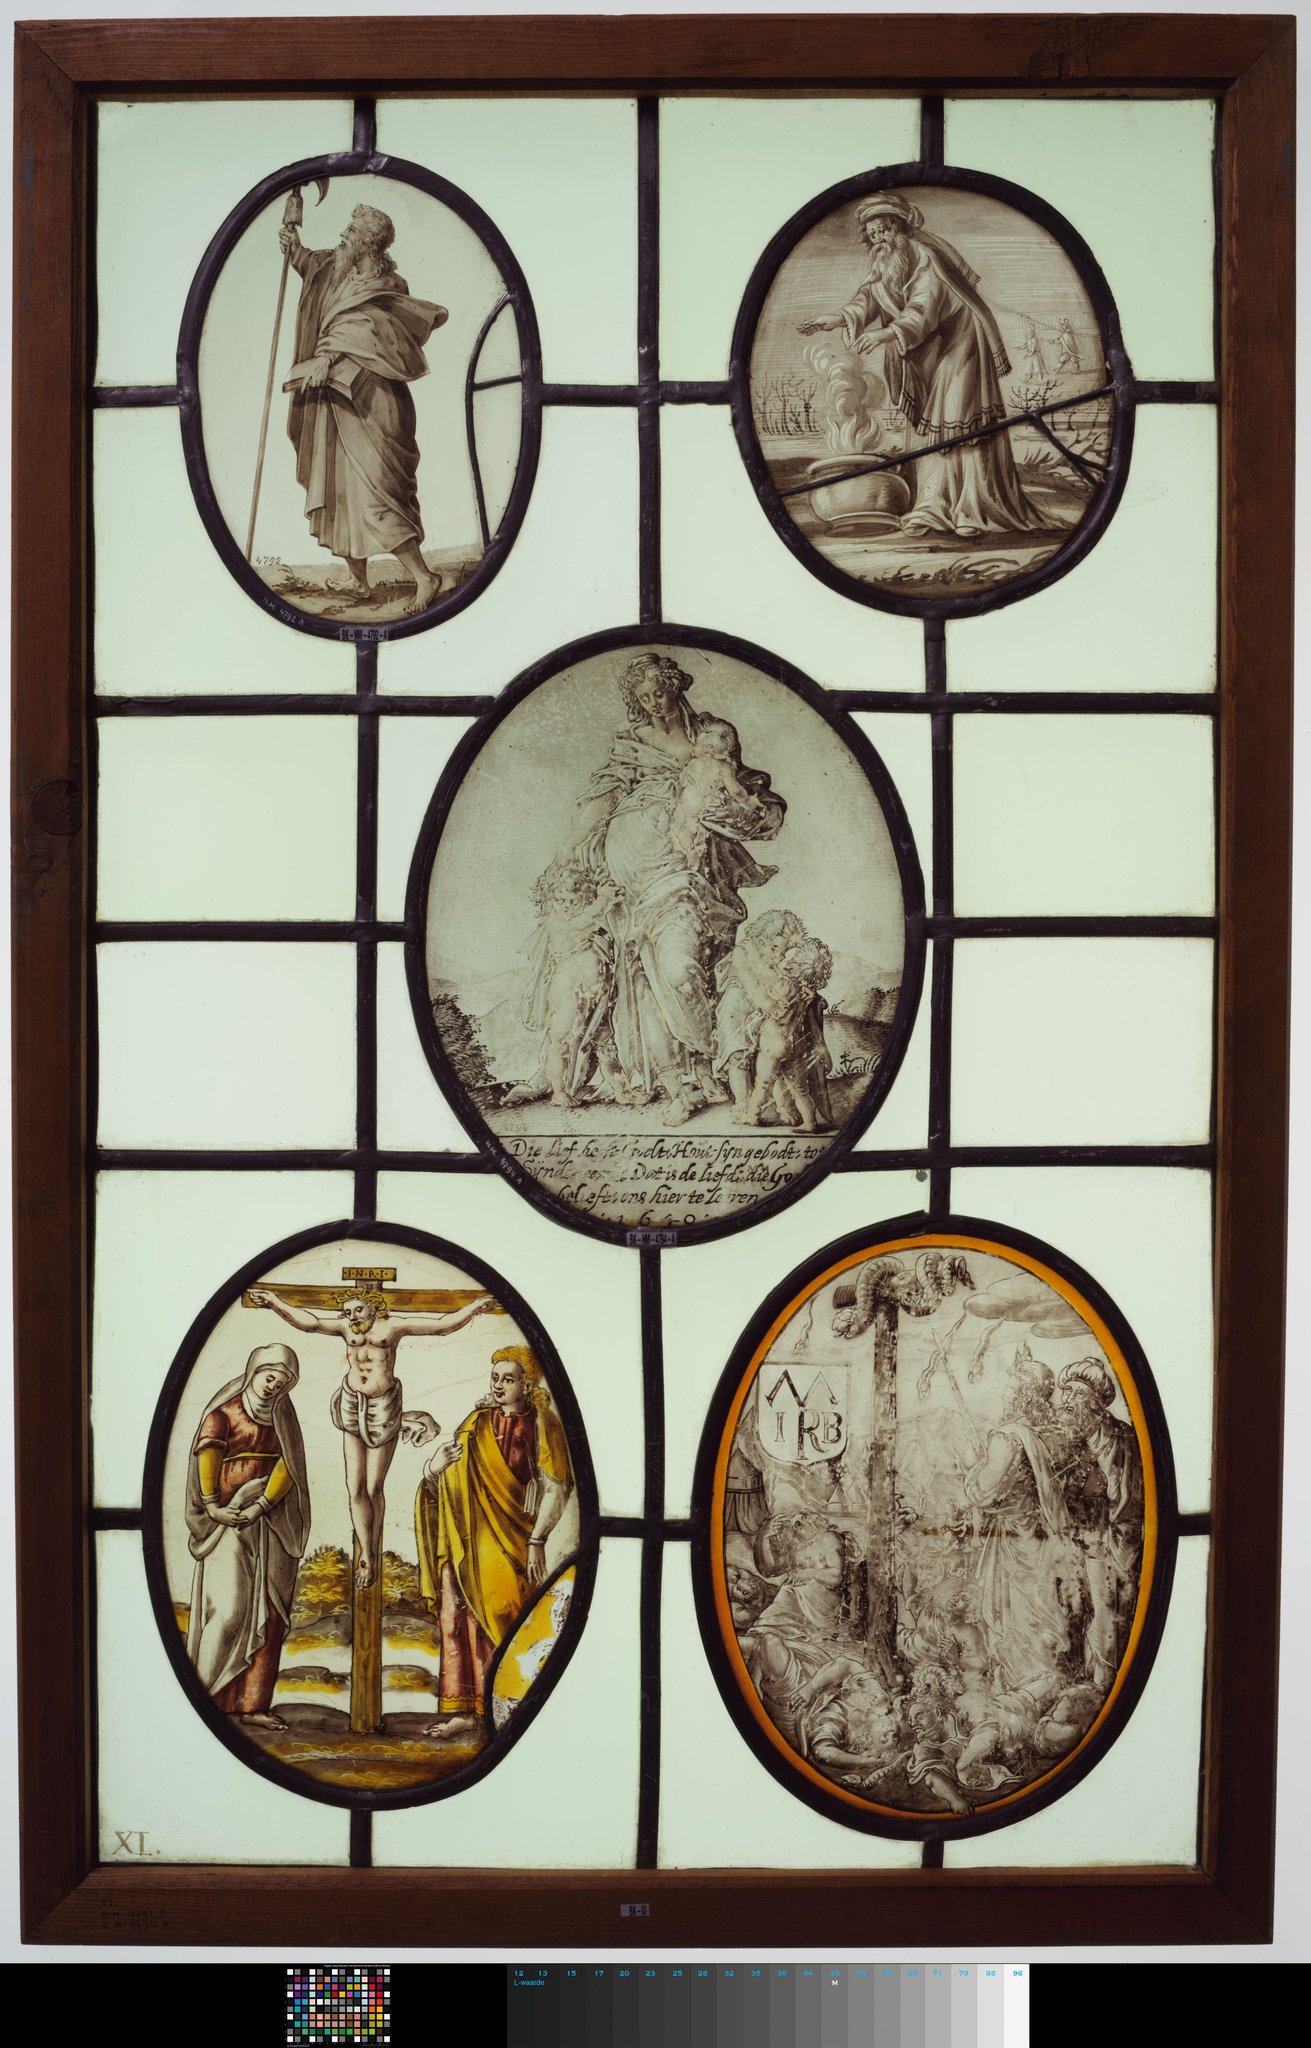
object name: light window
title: Ruit met de Goddelijke Liefde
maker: Anonymous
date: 1640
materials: glass, lead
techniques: leading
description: Ovale ruit waarop afgebeeld "de Goddelijke liefde" Een moeder met vier kinderen waarvan twee elkaar omhelzen. Met opschrift.